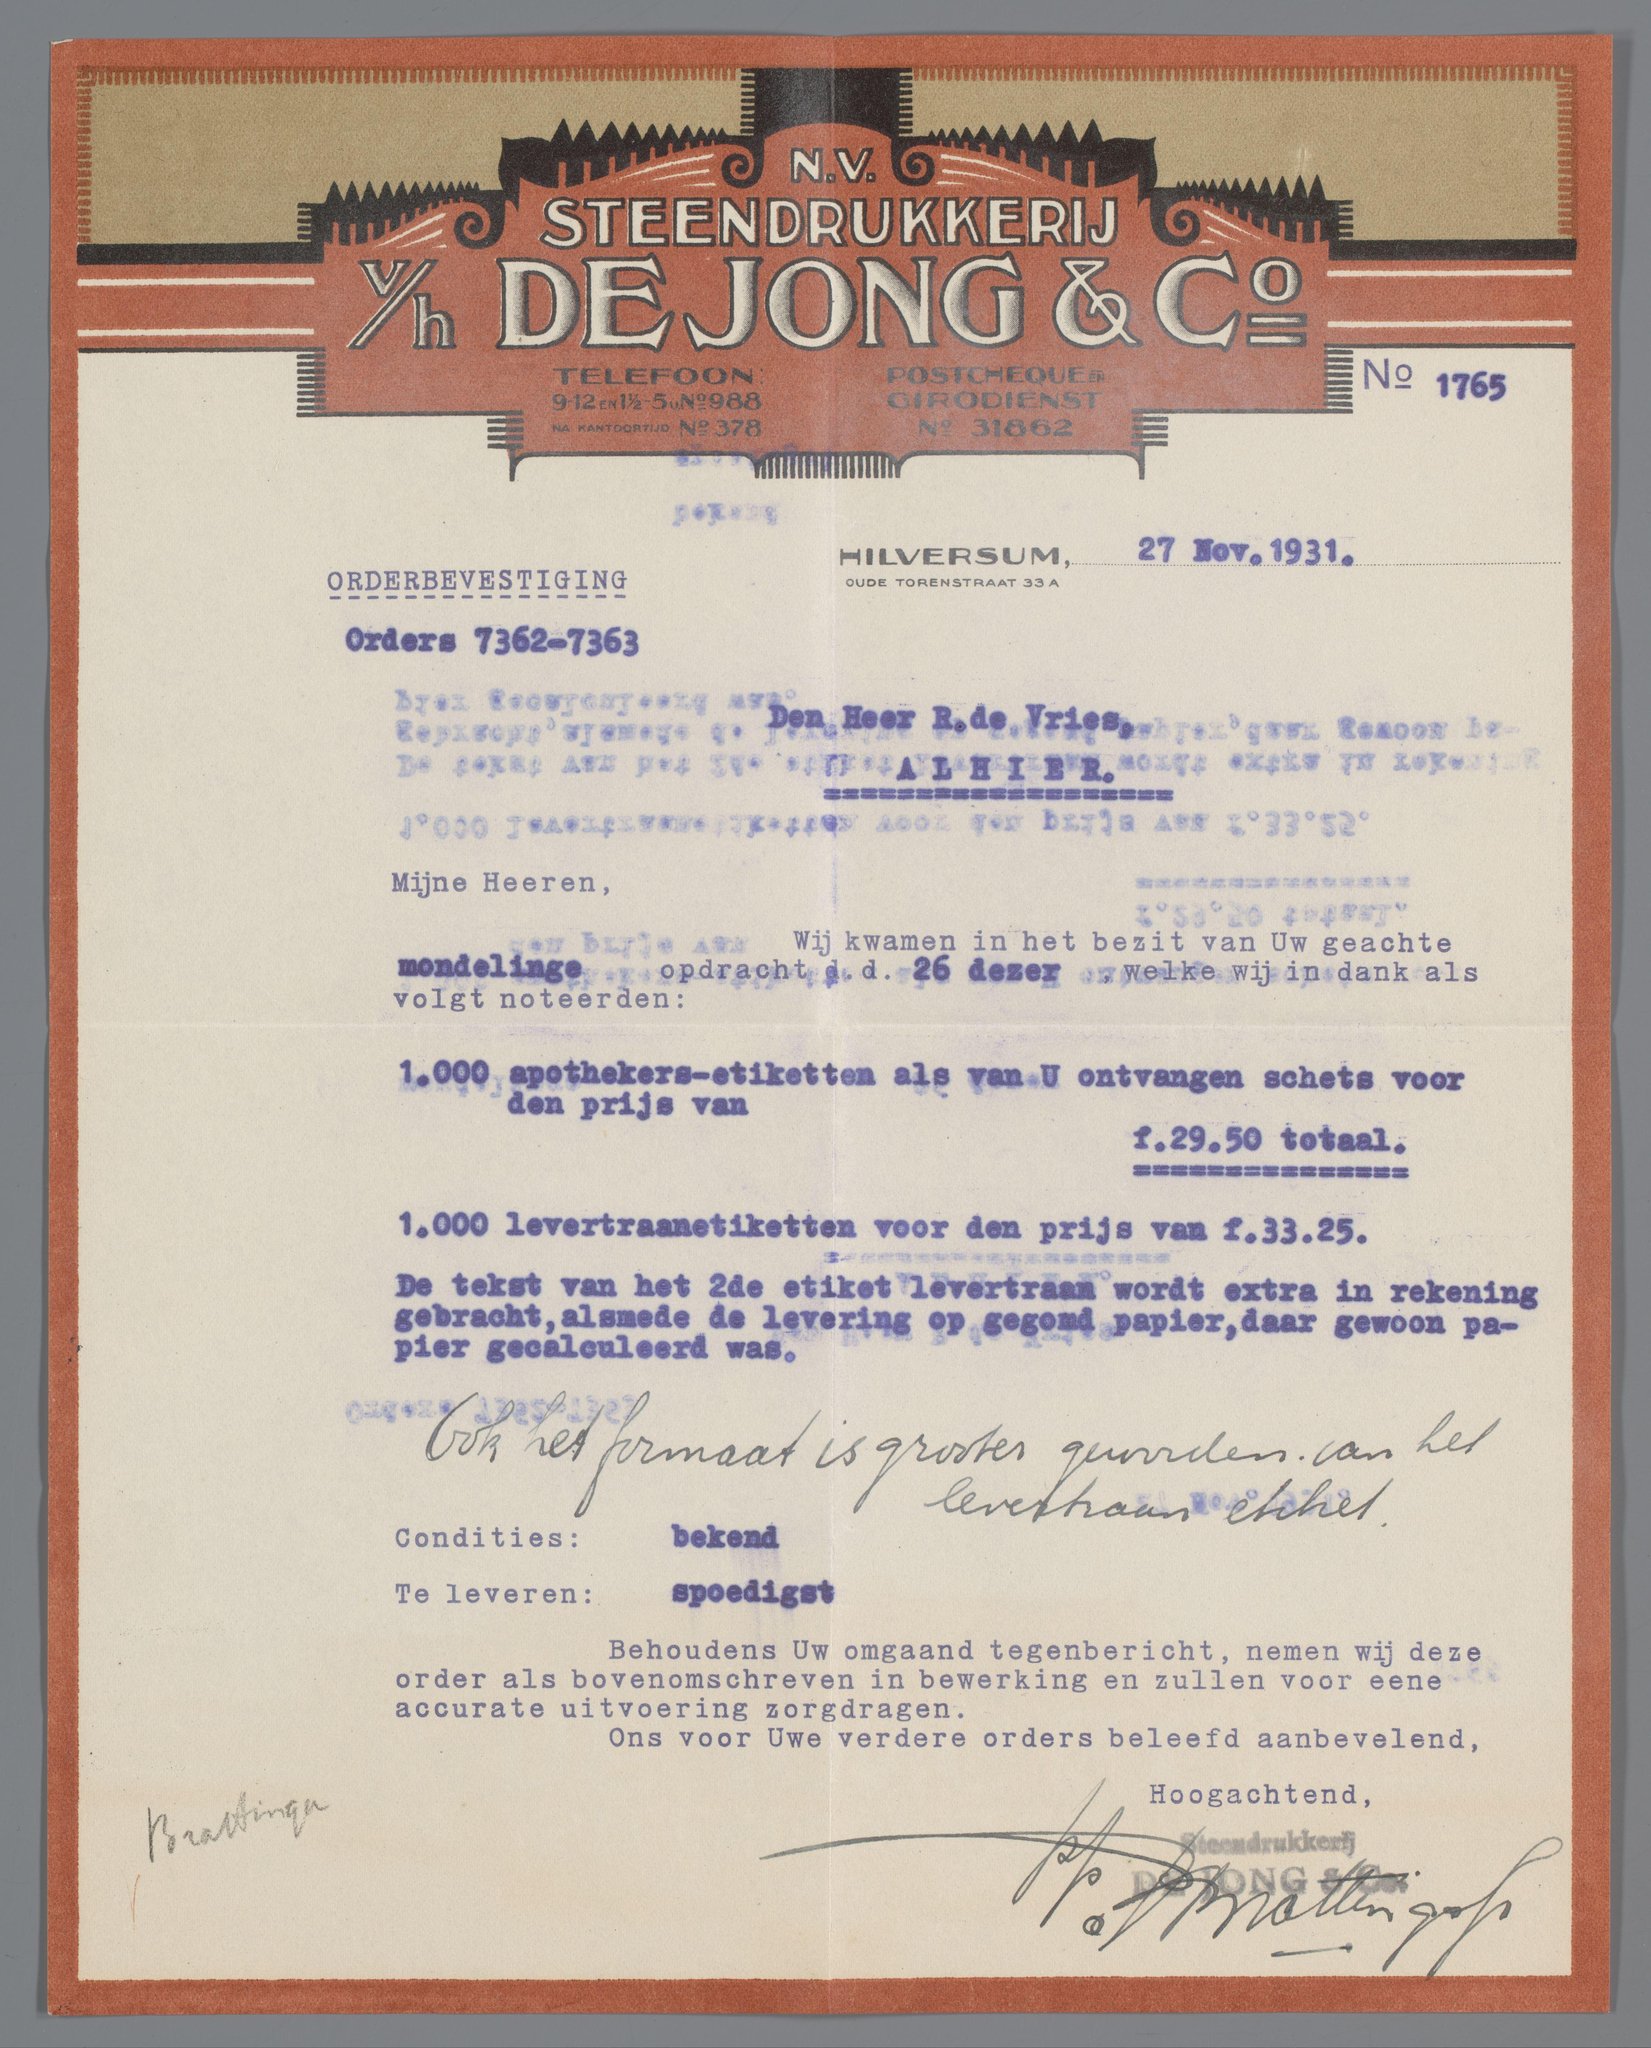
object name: letter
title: Brief aan R.W.P. de Vries Jr.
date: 1931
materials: ink, paper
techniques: pen, typewriting, writing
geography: hilversum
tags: amsterdam, print maker, draughtsman, reinier willem petrus de vries (1874-1953), the graphic arts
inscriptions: name: ‘N.V./ STEENDRUKKERIJ/ v/h DE JONG & Co’